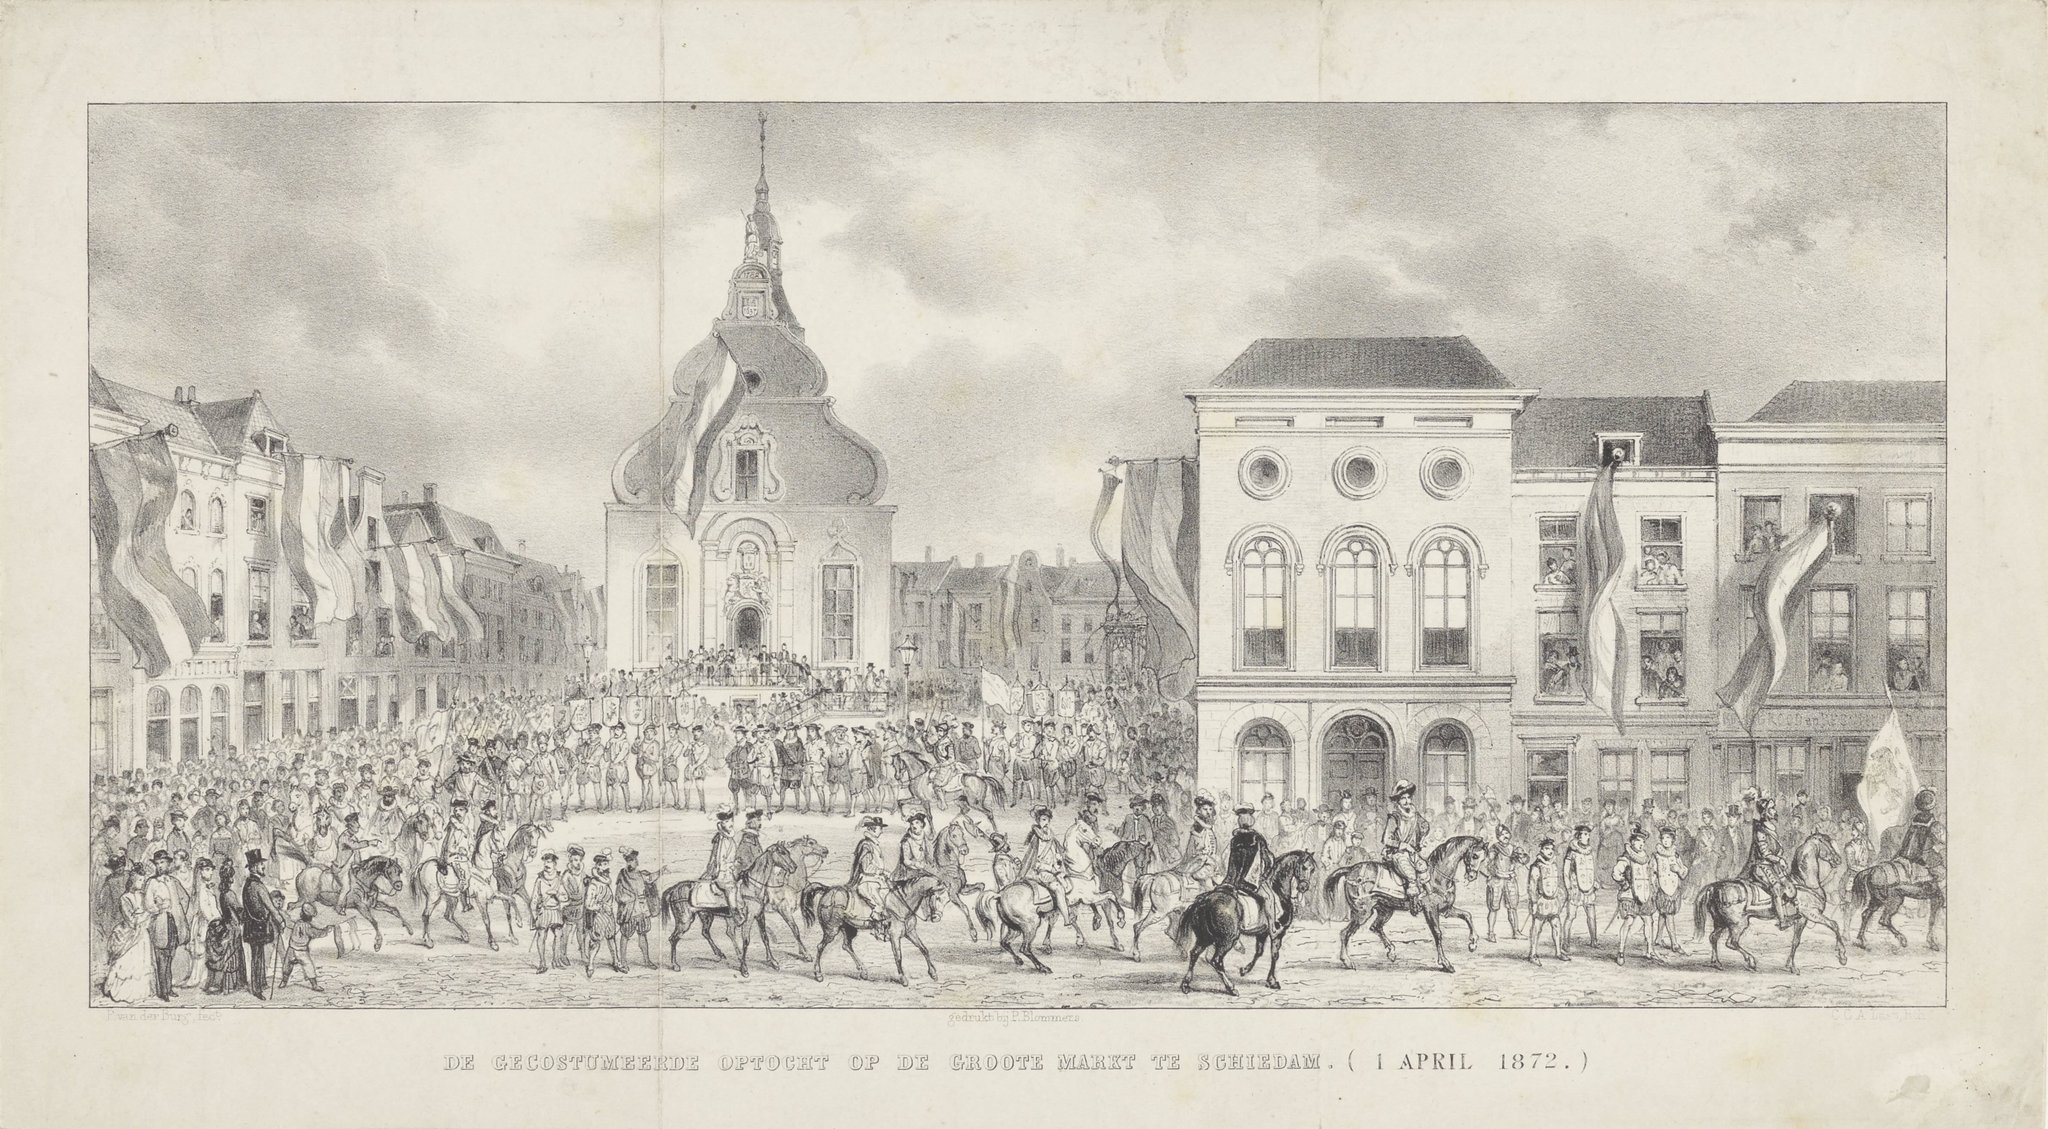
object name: print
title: De Gecostumeerde Optocht op de Groote Markt te Schiedam. (1 April 1872.)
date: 1872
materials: paper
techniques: lithograph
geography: netherlands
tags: public festivities (+ parade, pageant, cavalcade ~ festive activities), costumes used in pageants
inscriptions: collector's mark: Lugt 2228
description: Historisch gecostumeerde optocht bij de viering van 300 jaar Nederlandse vrijheid 1572-1872. Optocht gehouden te Schiedam op 1 april 1872. De stoet slingert zich over de Grote Markt voor het stadhuis.